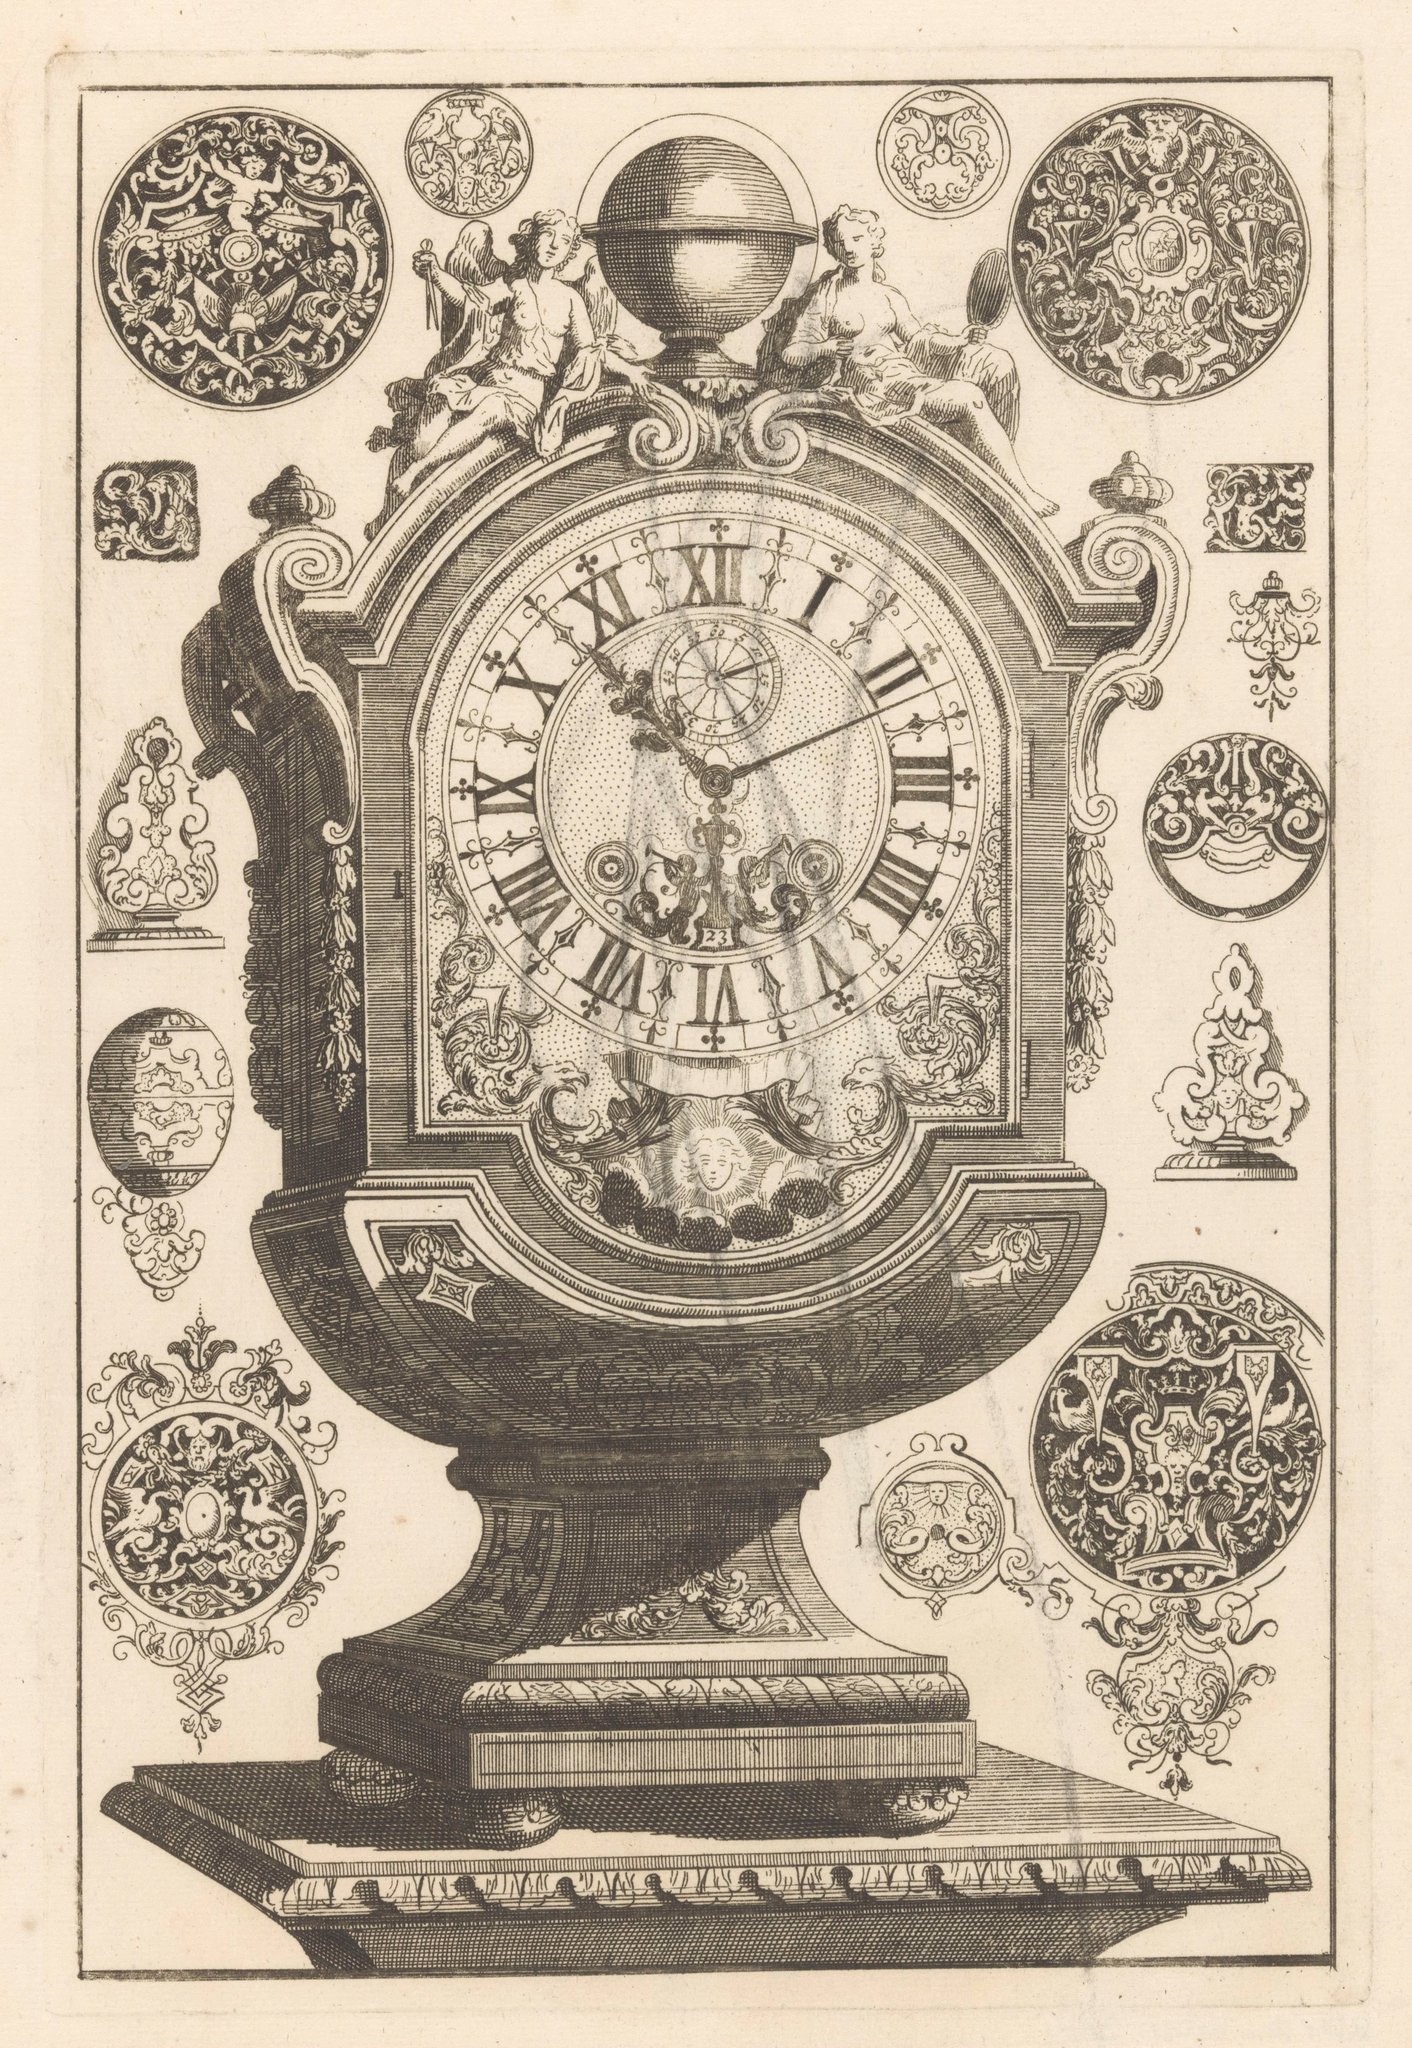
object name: ornament print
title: Pendule bekroond met wereldbol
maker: Anonymous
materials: paper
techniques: etching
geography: netherlands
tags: clock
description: Een pendule bekroont met een wereldbol, geflankeerd door personificaties van Astronomie en Waarheid. De pendule is omringd door vier decoraties voor wijzerplaten of horlogekasten en tien andere ornamenten.